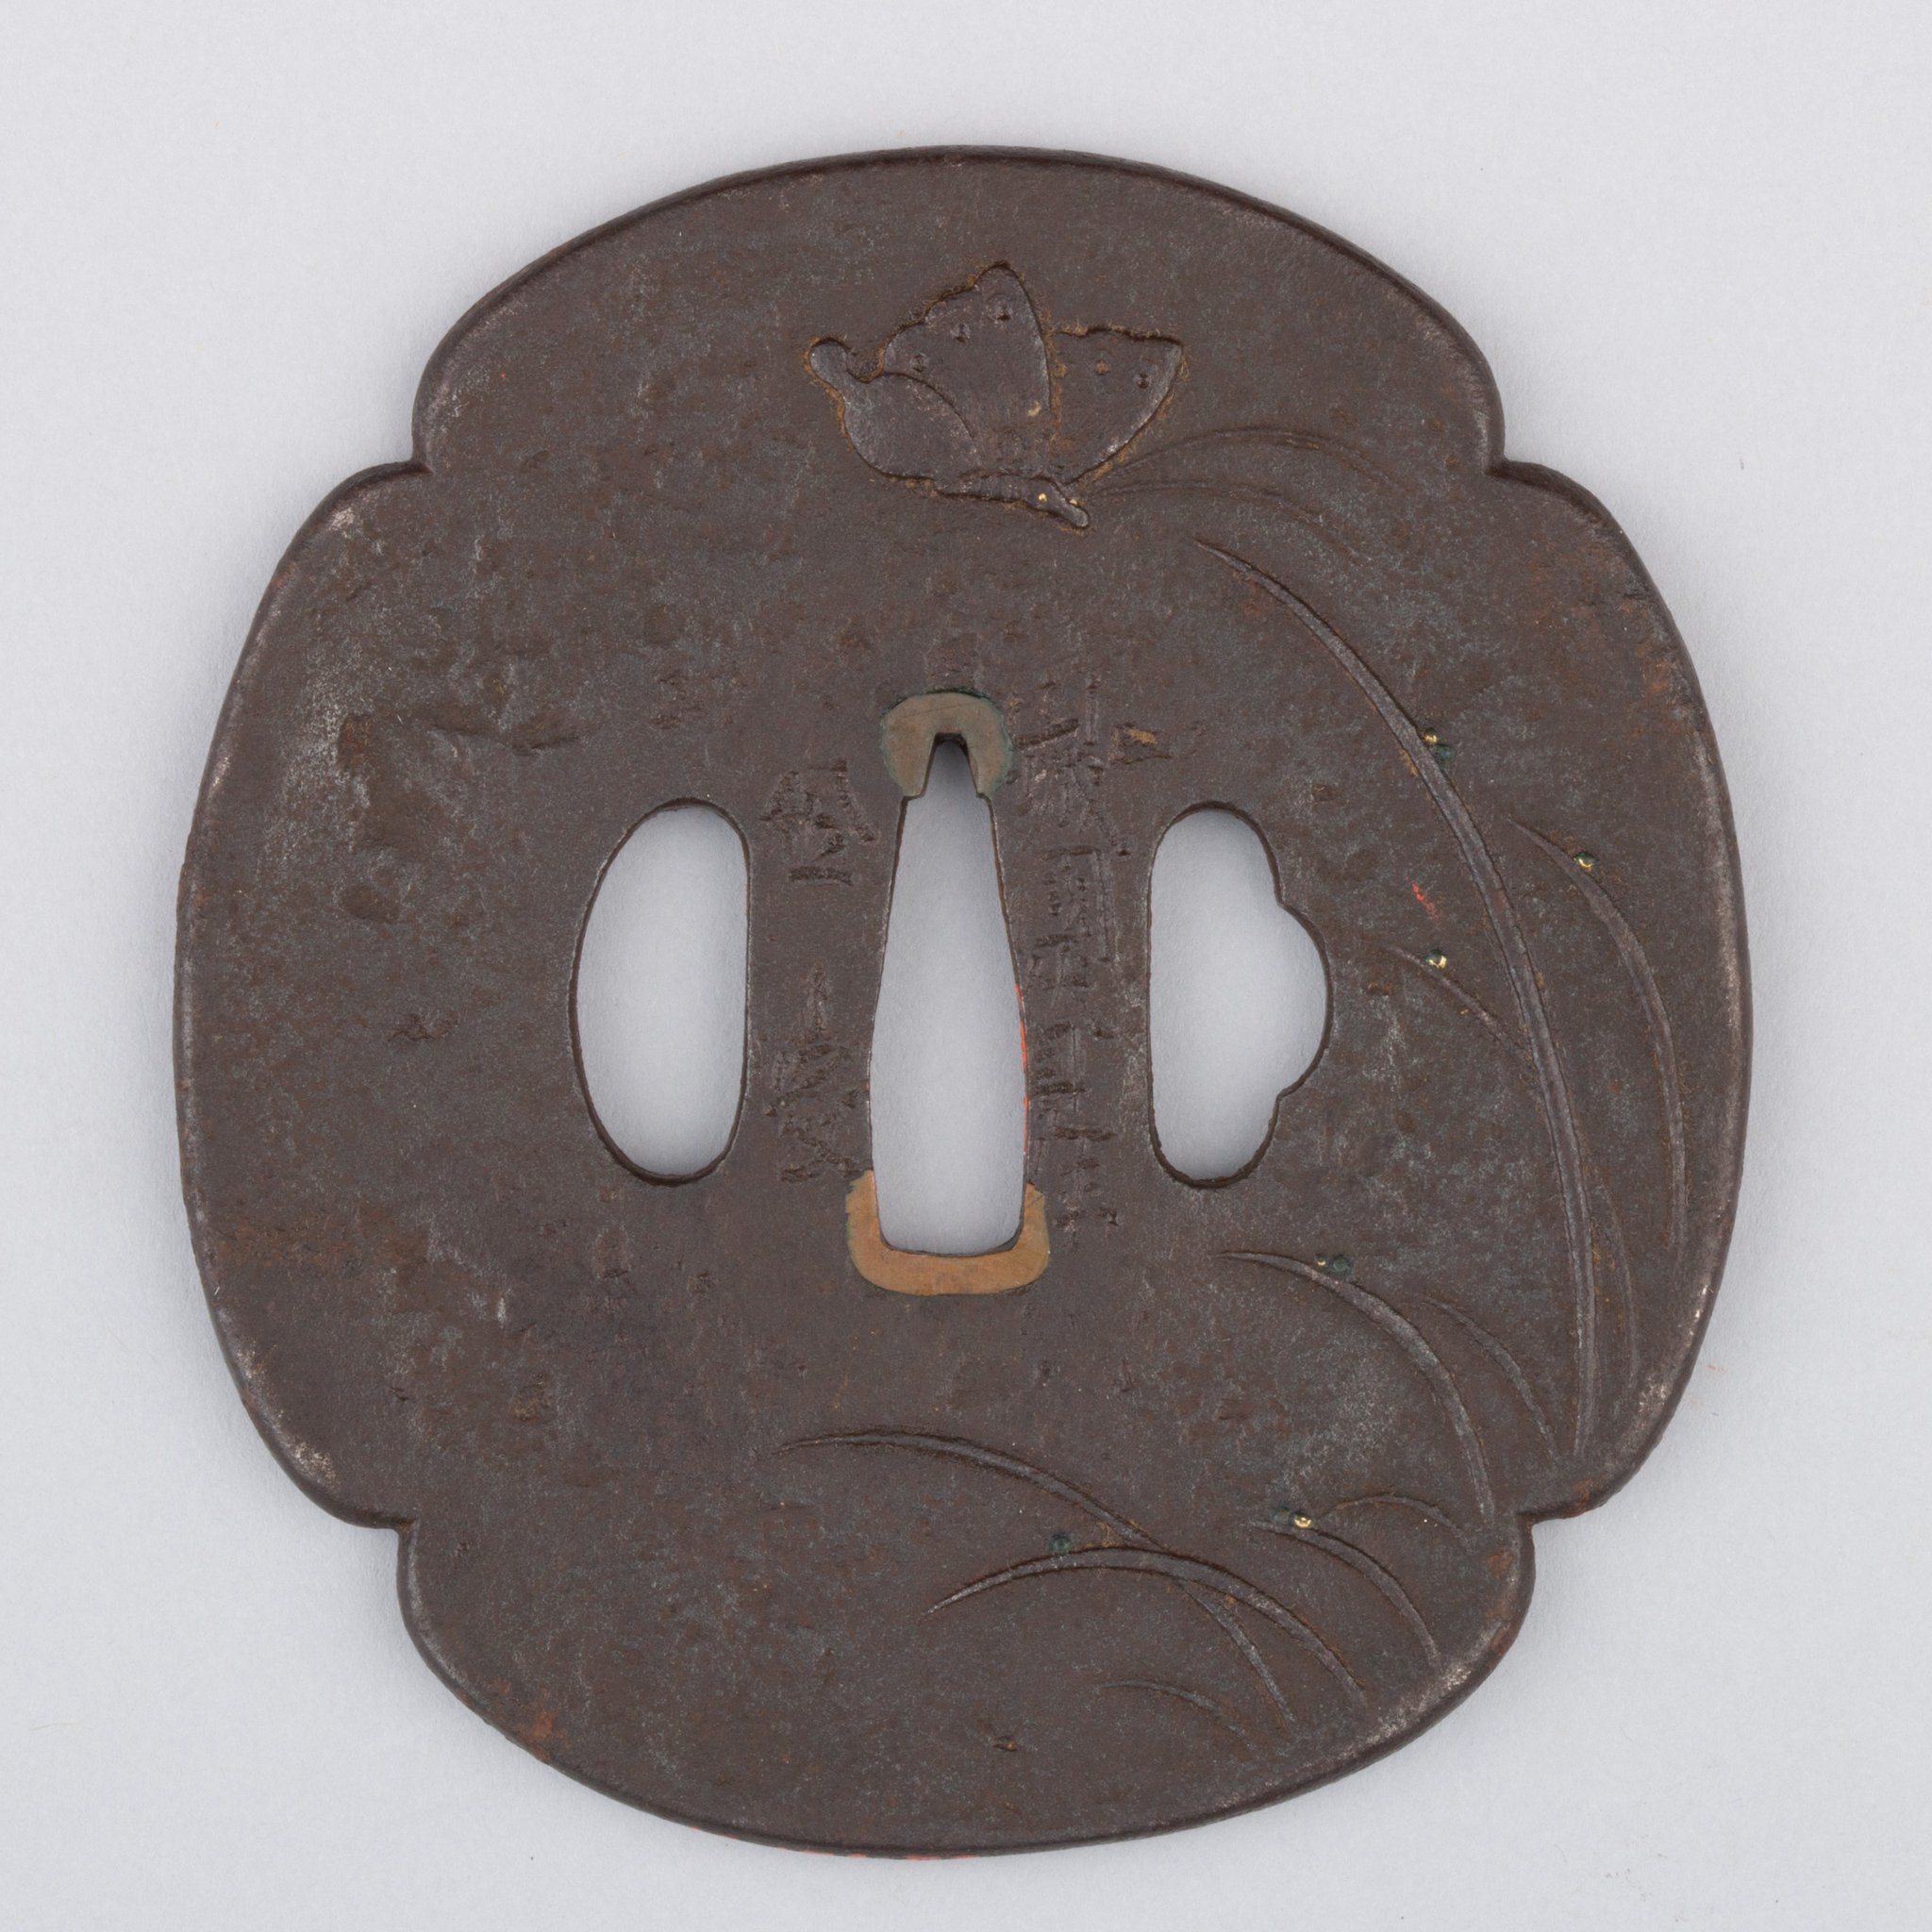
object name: sword guard tsuba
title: Sword Guard (Tsuba)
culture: japanese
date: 1615-1868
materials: copper, iron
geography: japan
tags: butterflies